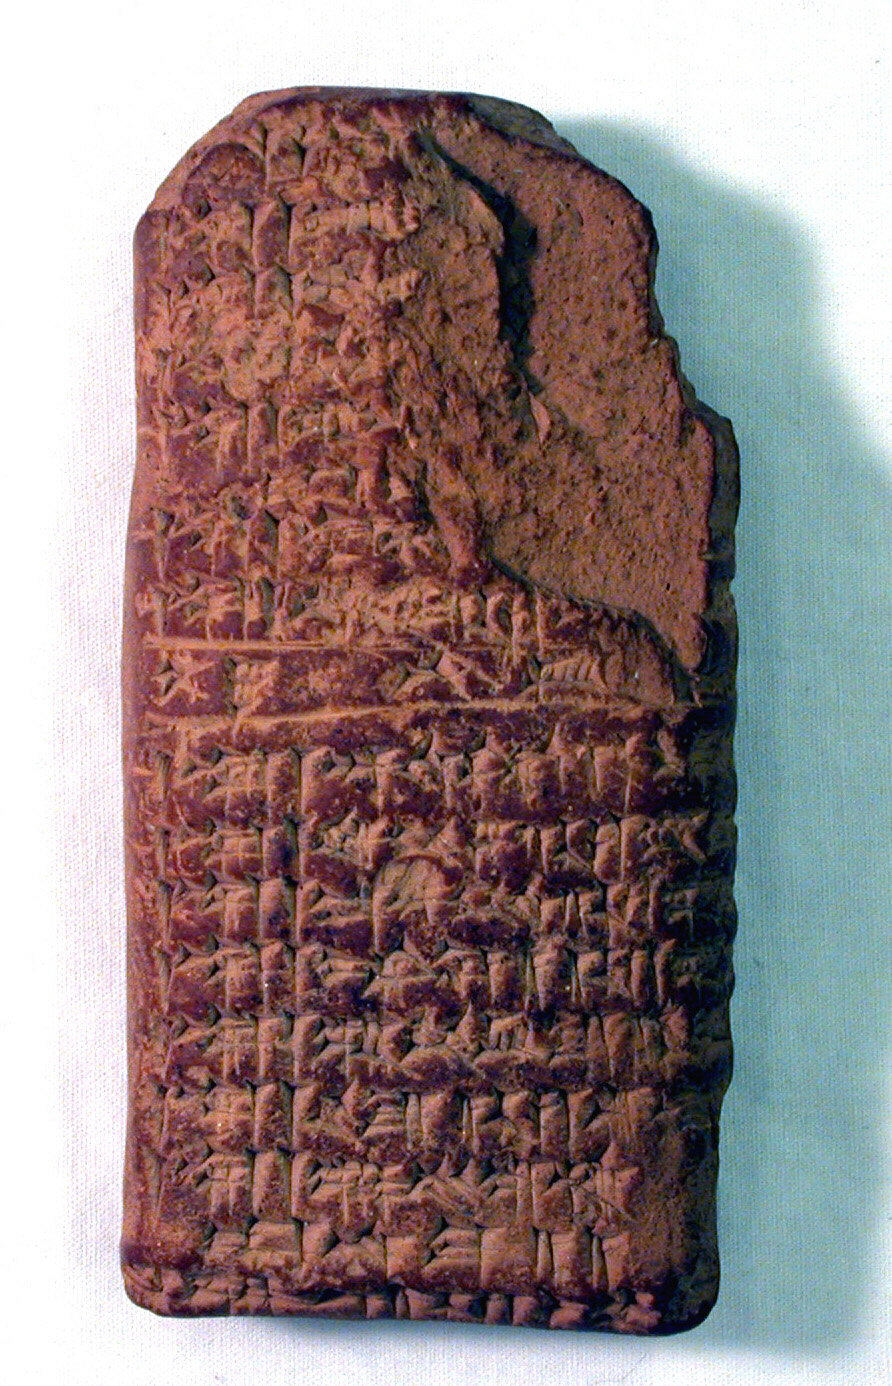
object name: cuneiform tablet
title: Cuneiform tablet: account of sheep holdings in households for offerings, Ebabbar archives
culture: babylonian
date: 626-562 BCE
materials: clay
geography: mesopotamia